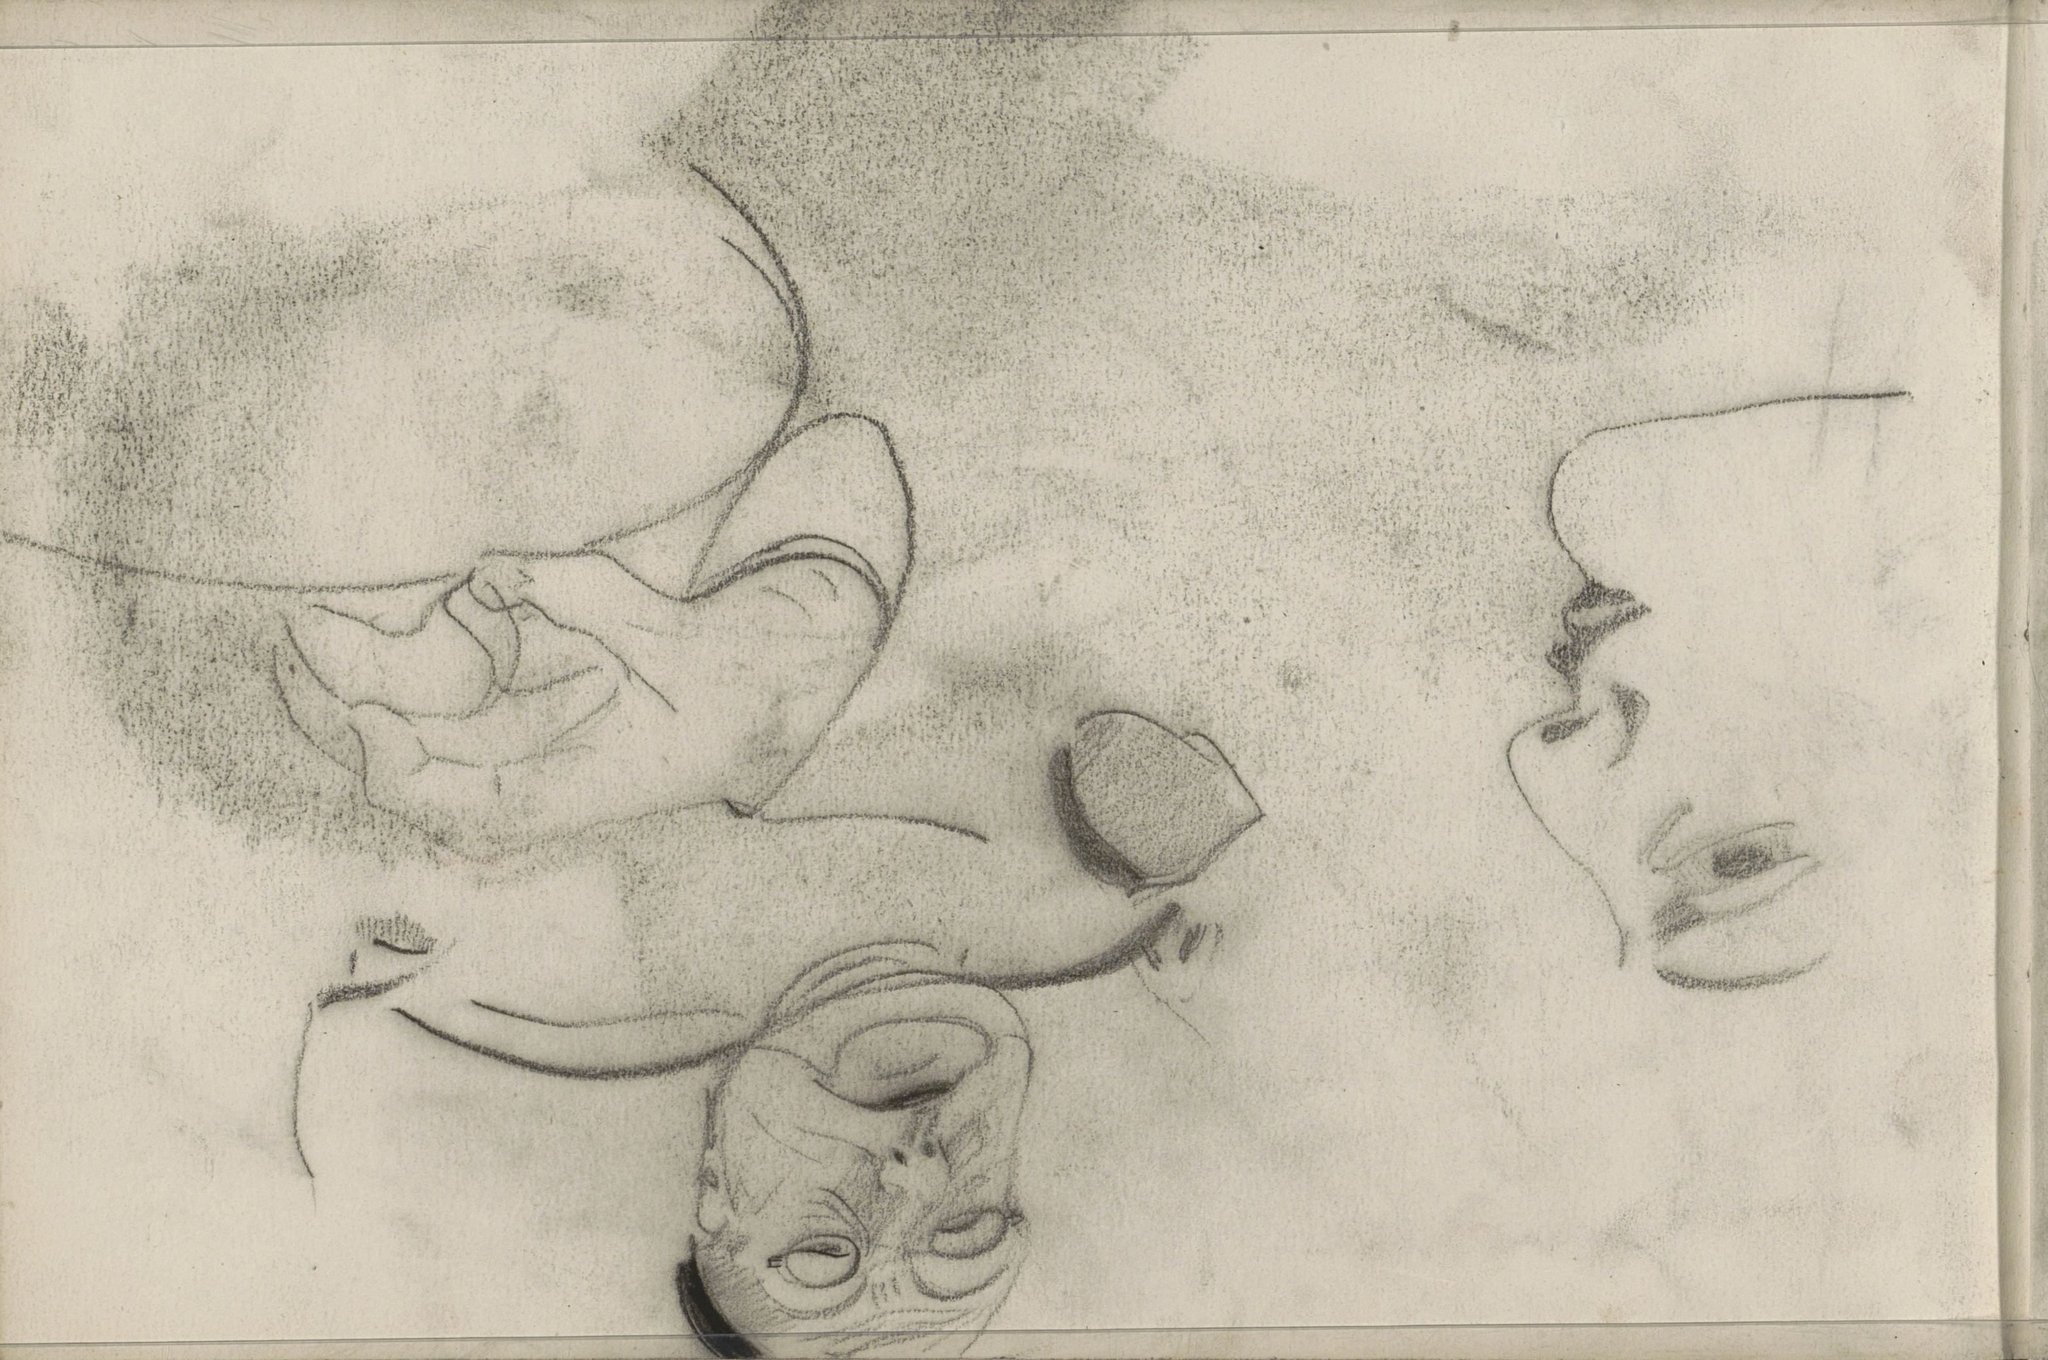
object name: sketchbook leaf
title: Mannenkop, gezicht van een vrouw en een hand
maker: carel adolph lion cachet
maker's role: draughtsman, print maker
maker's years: 1864-1945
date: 1895-1900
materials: chalk, paper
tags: face, hand, head (human) (+ male human being (not to be used where -a- is prescribed))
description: Blad 4 verso uit een schetsboek met 19 bladen.